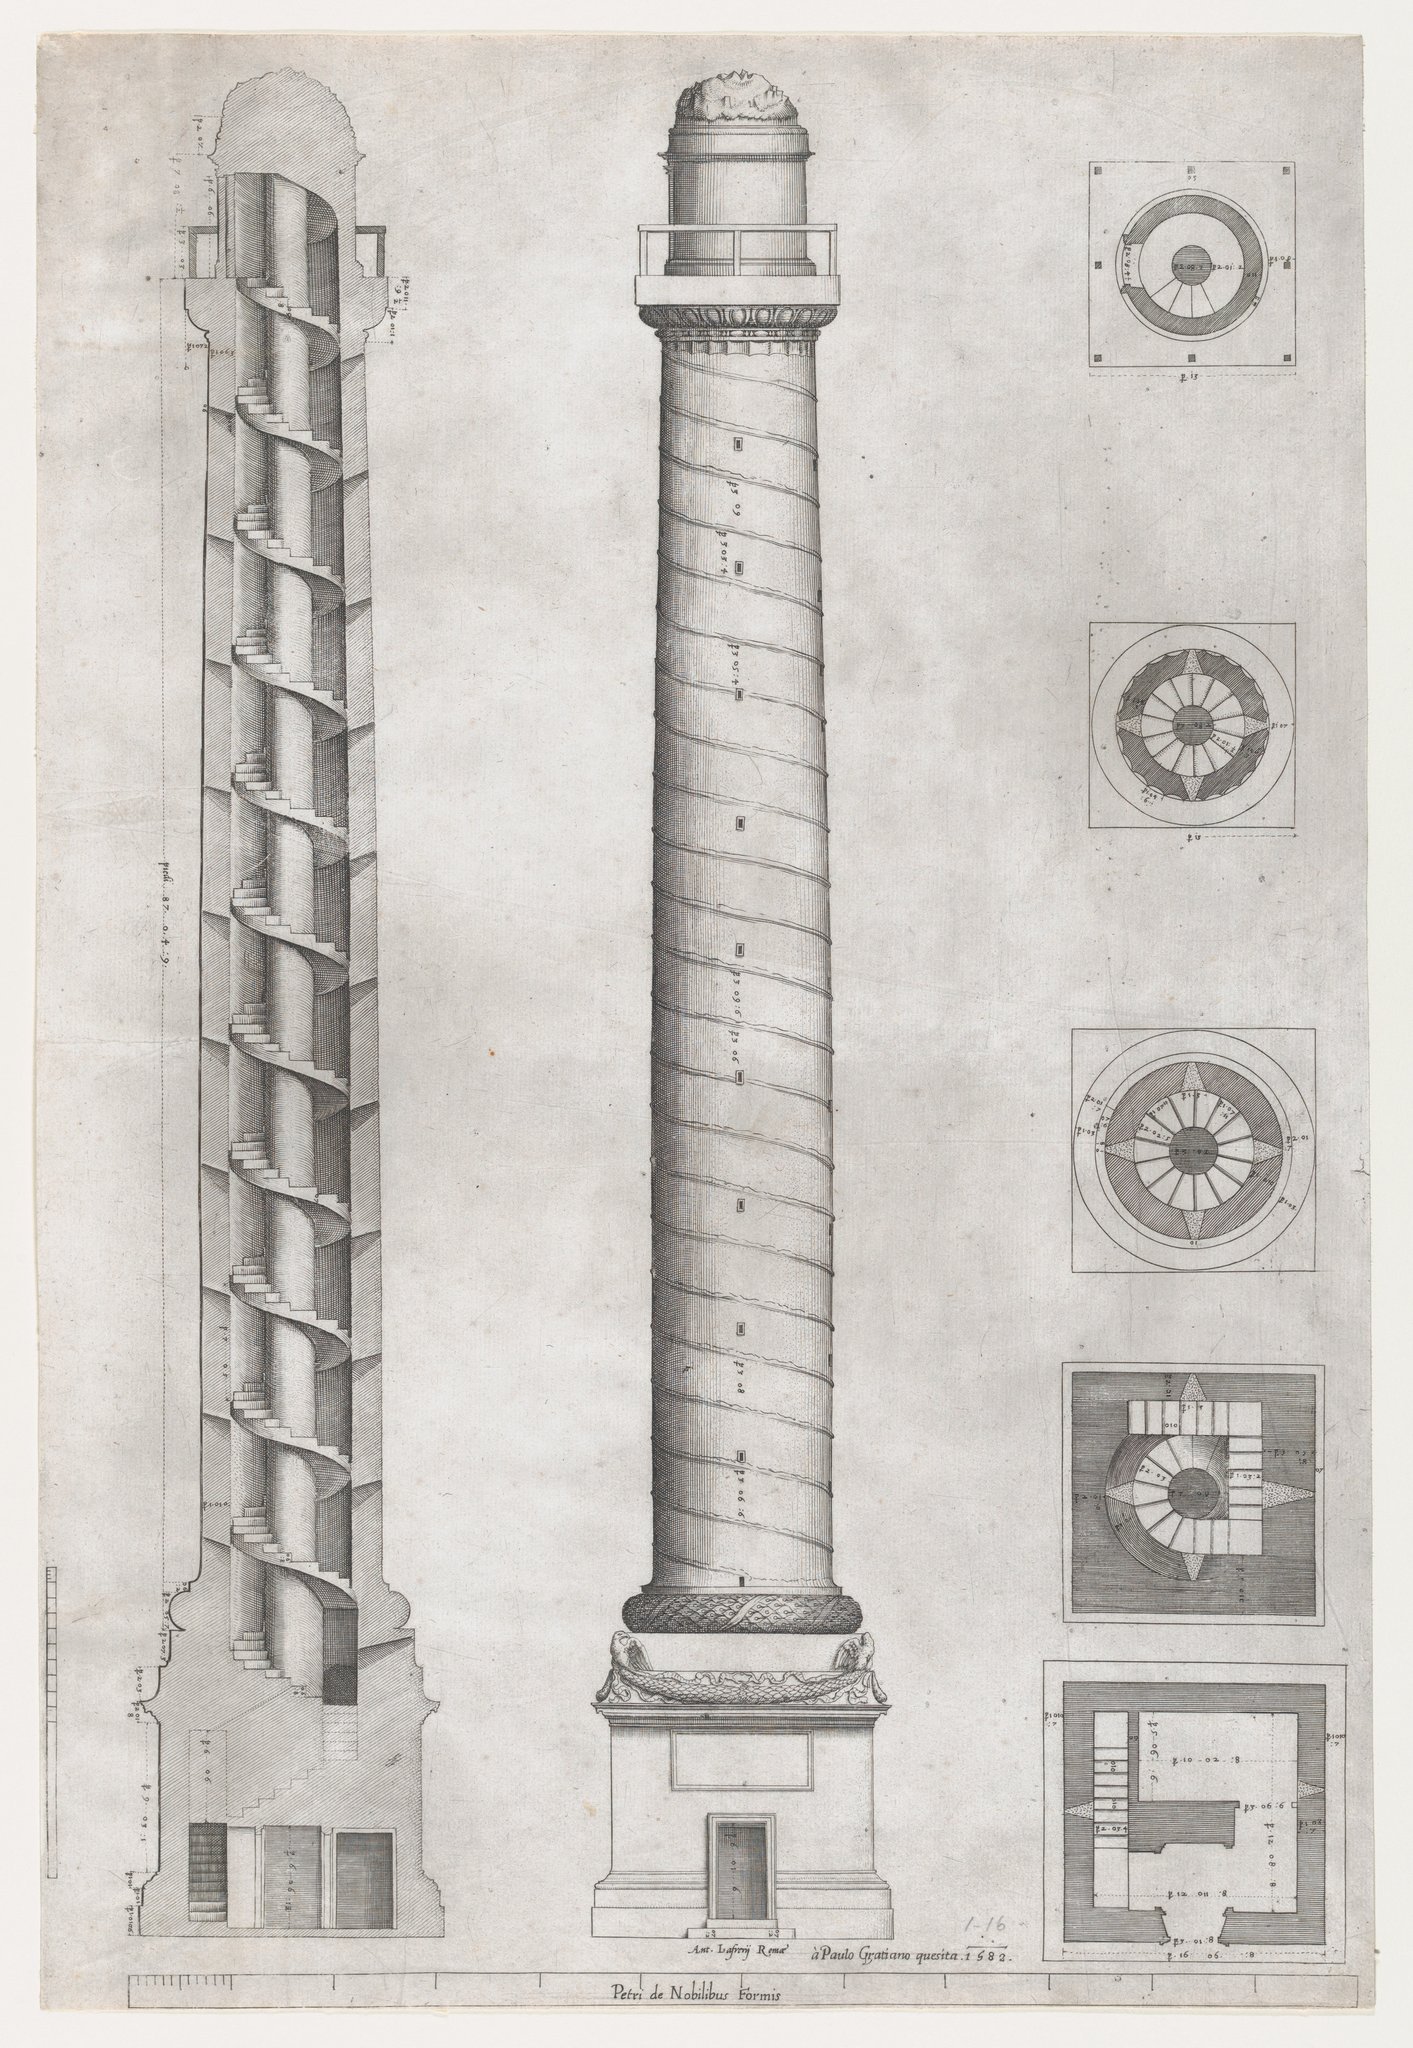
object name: print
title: Column of Trajan, from "Speculum Romanae Magnificentiae"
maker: Anonymous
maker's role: artist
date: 1582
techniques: engraving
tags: architecture,columns,rome